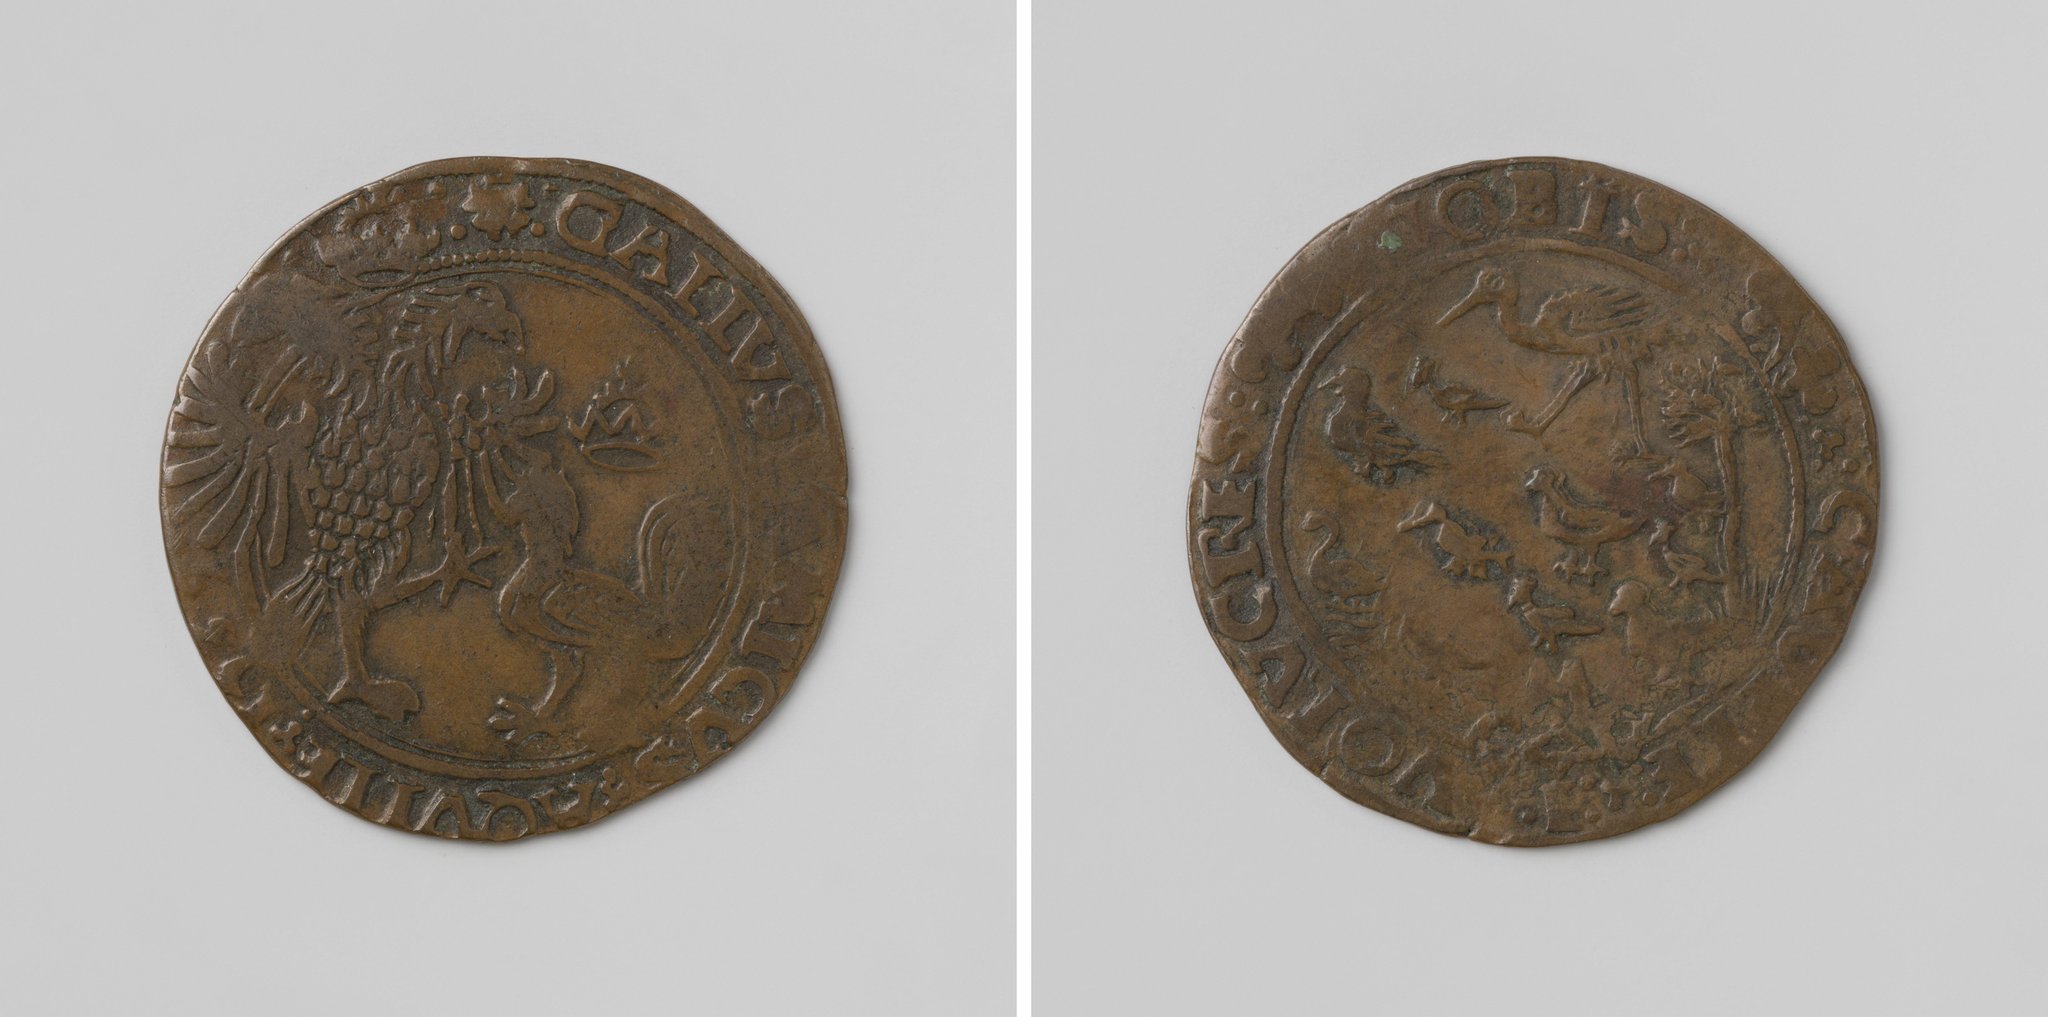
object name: jeton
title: Verdrag van Toledo tussen Karel V, Duits keizer en Frans I, koning van Frankrijk, rekenpenning ten behoeve van Mr. Claes van Essche, lid van de rekenkamer van Holland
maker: Anonymous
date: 1539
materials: copper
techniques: striking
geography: netherlands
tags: frans i van valois-angoulême (koning van frankrijk), charles v (holy roman emperor and king of spain), holland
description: Koperen penning. Voorzijde: adelaar en haan, ieder onder eigen kroon binnen omschrift. Keerzijde: vogels, geleid door een ooievaar boven monogram, bestaande uit letters M, C, V en E binnen omschrift